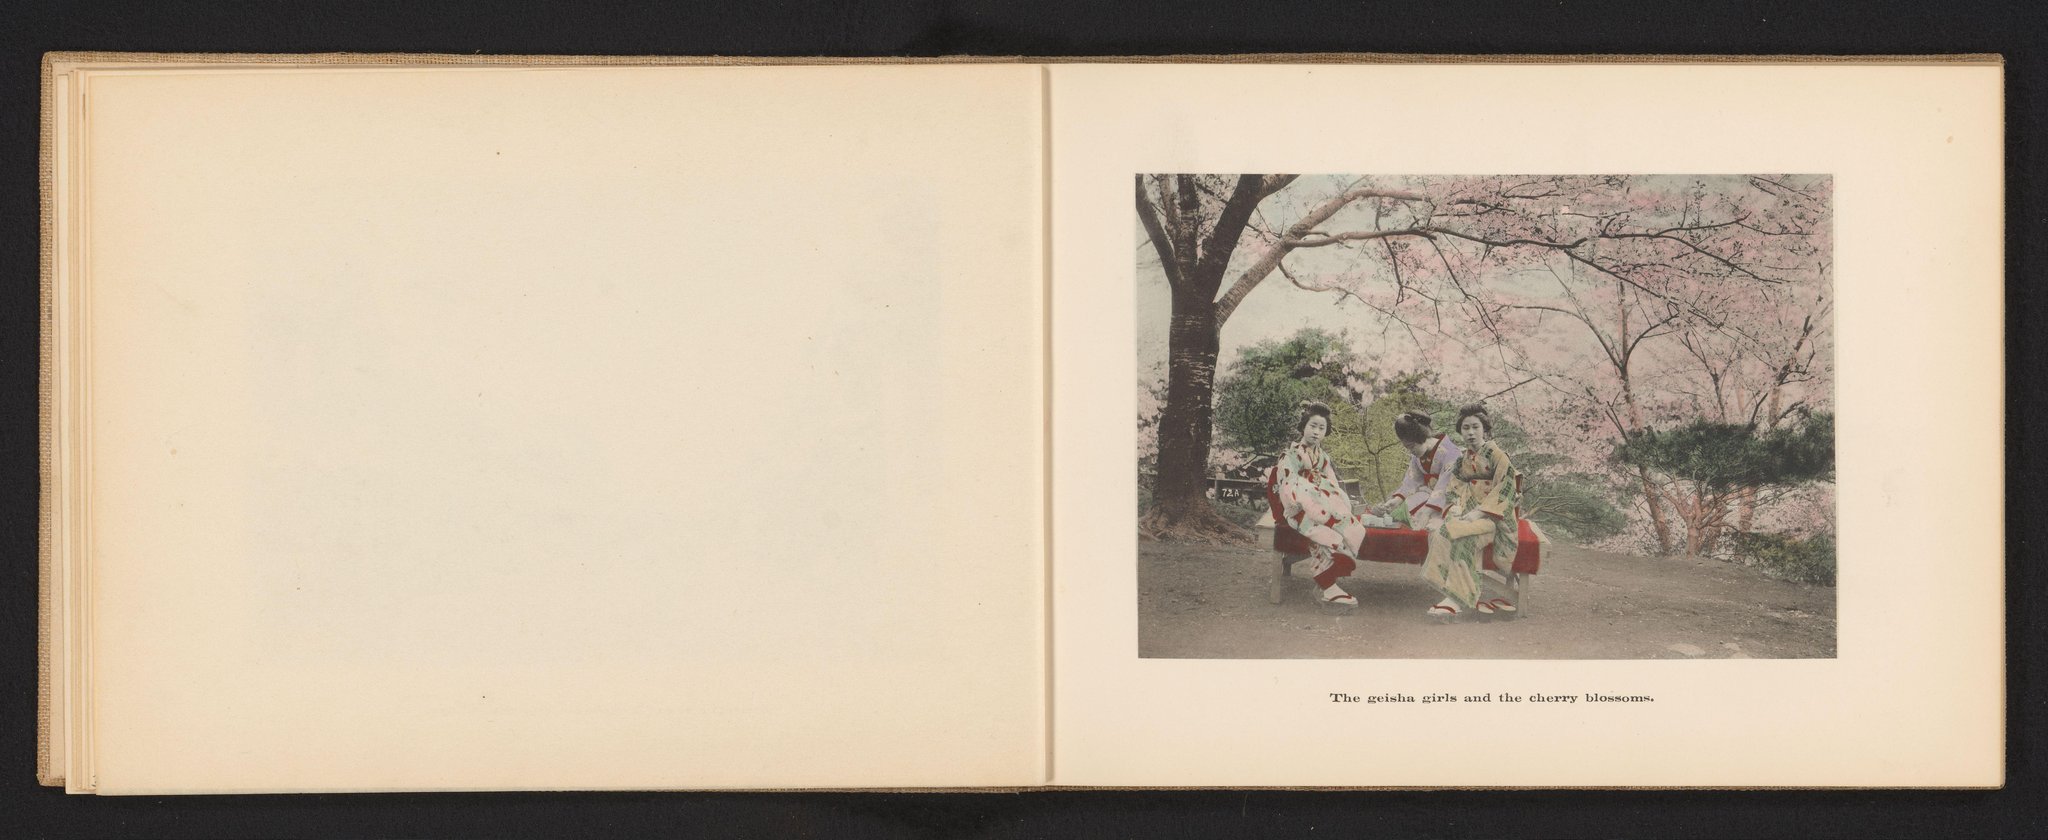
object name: photomechanical print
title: Drie vrouwen in traditionele Japanse kleding op ene bank onder kersenbloesem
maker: kōzaburō tamamura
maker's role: fotograaf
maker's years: 1856-1923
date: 1895-1905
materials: paper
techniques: photograph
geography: japan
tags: trees: cherry-tree, folk costume, regional costume, japan